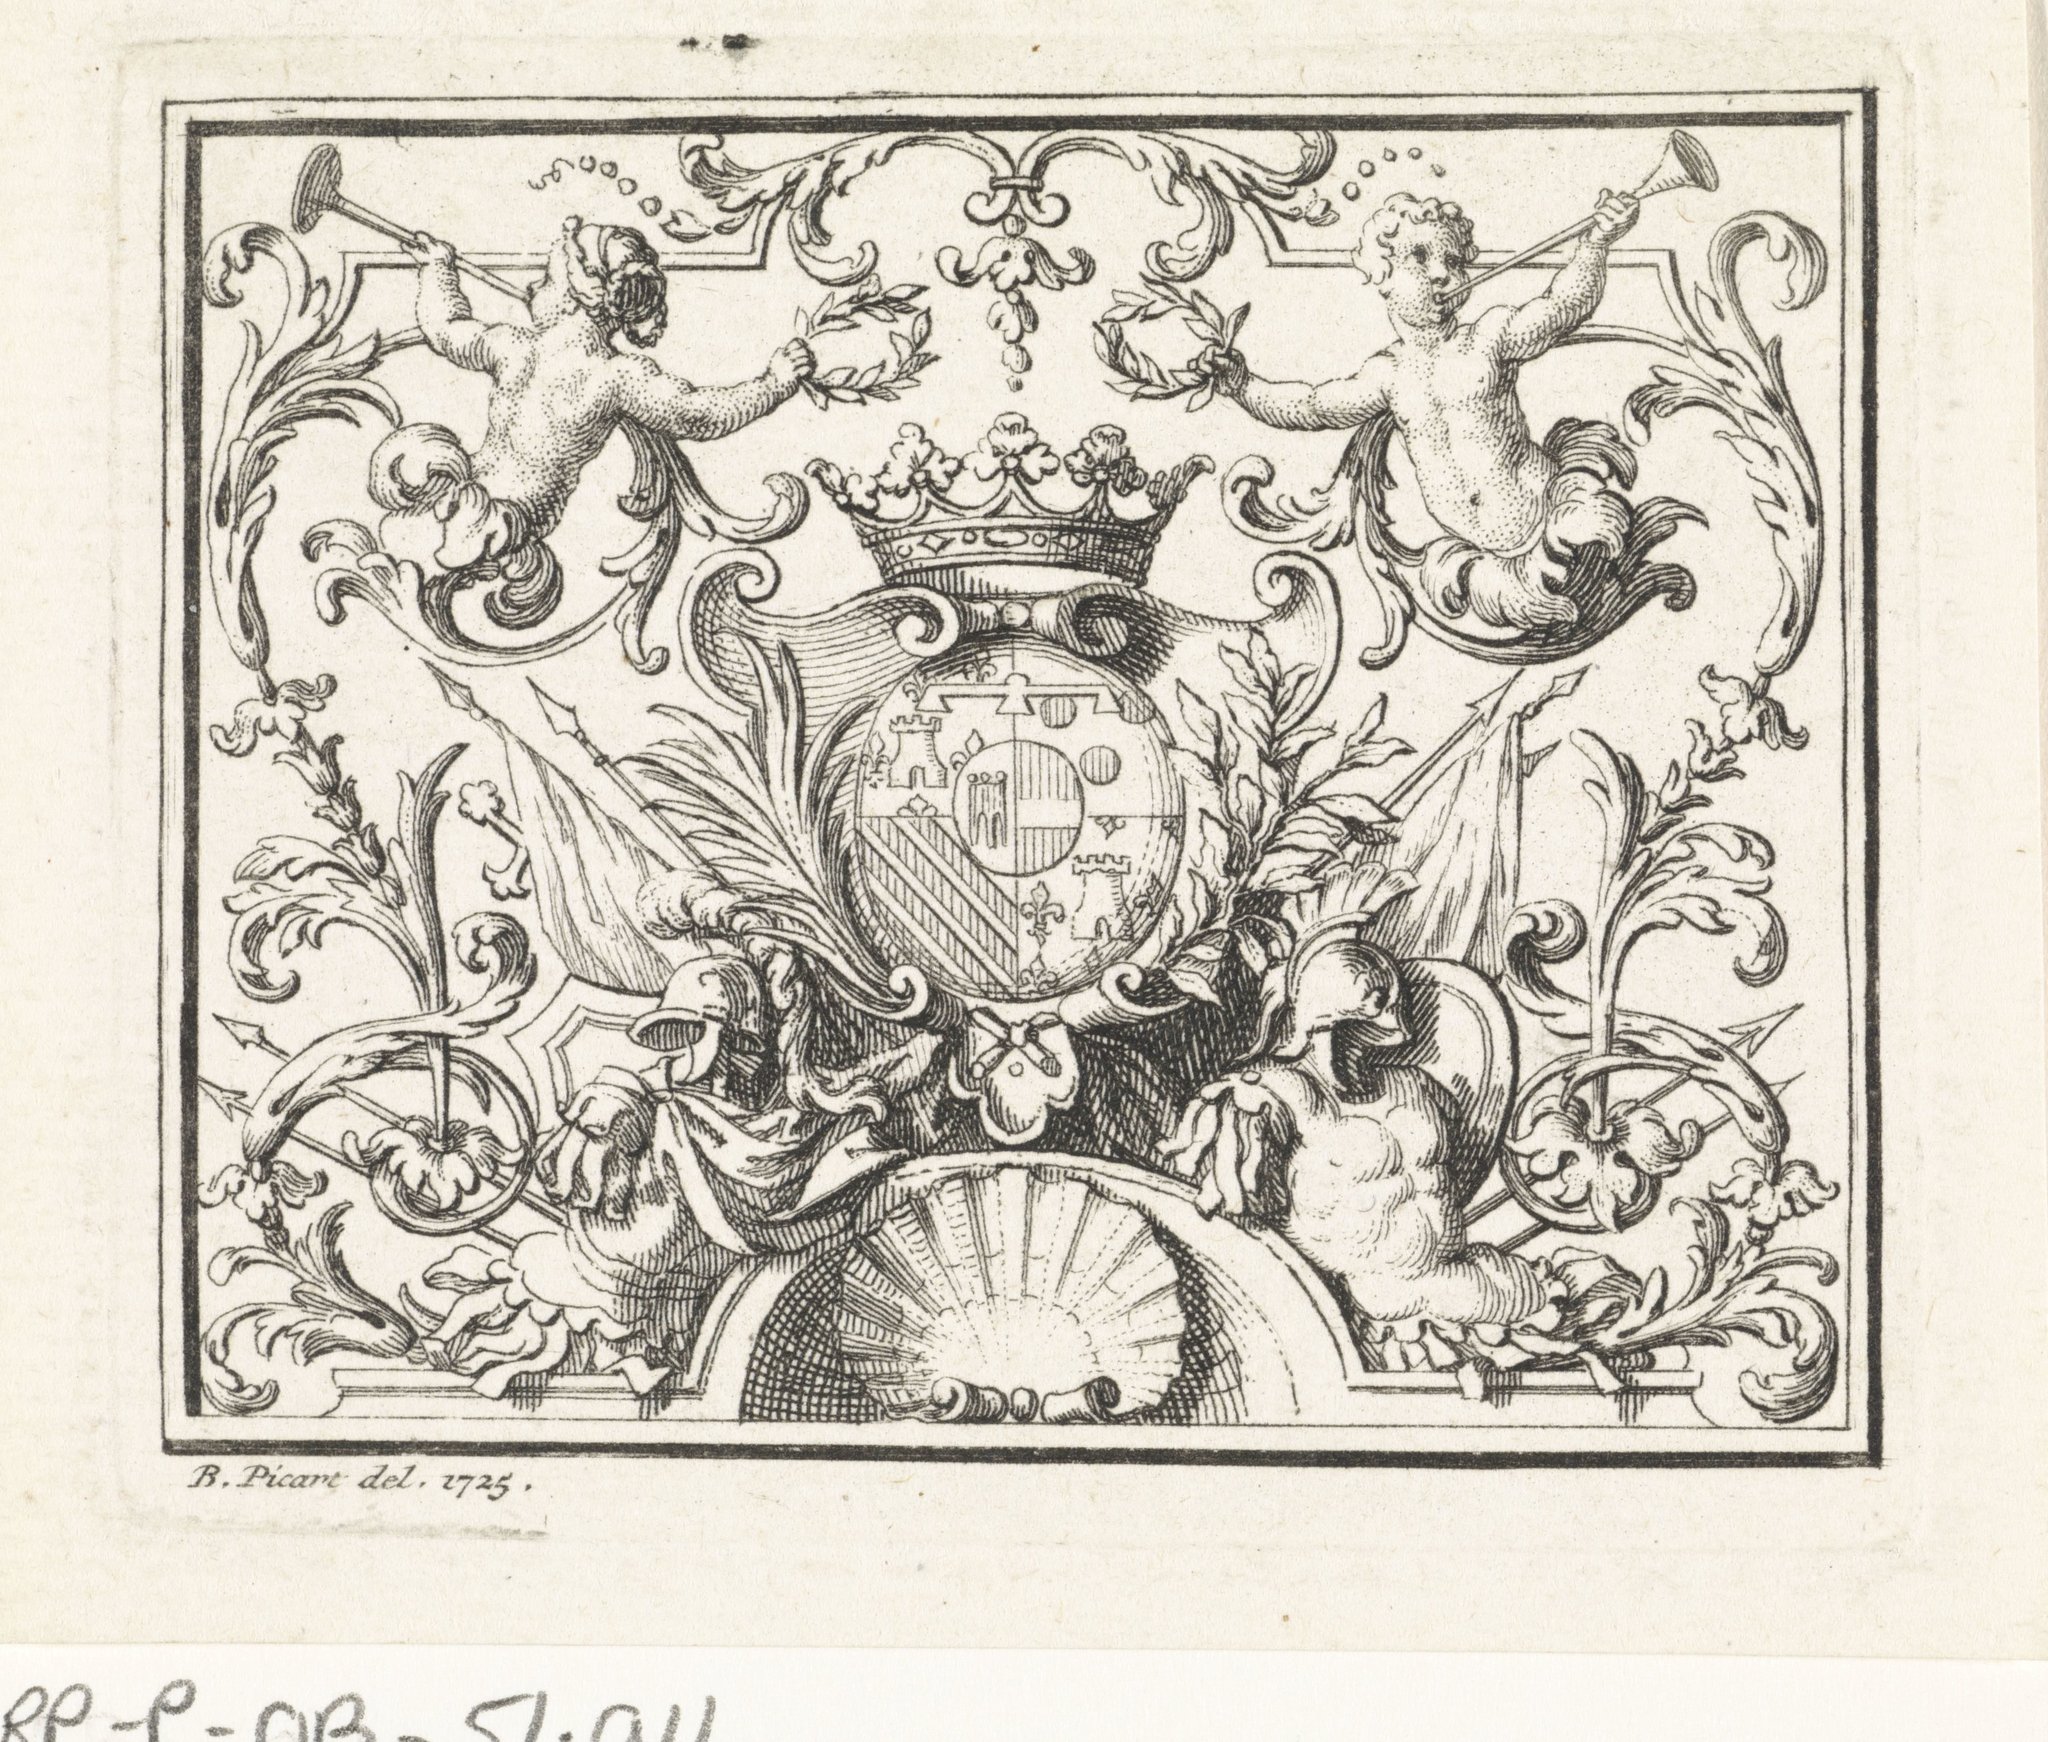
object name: print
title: Gekroond wapenschild in ornamentele omlijsting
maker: bernard picart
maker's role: draughtsman, print maker, publisher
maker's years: 1673-1733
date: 1725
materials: paper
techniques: engraving, etching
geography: amsterdam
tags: coat of arms (as symbol of the state, etc.), fame; 'fama', 'fama buona', 'fama chiara' (ripa), foliage, tendrils, branches ~ ornament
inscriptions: collector's mark: Lugt 240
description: Een gekroond wapenschild in ornamentele omlijsting. Twee putti blazen de loftrompet en lauweren het wapenschild. Rond het schild wapenrustingen, lansen en banieren.